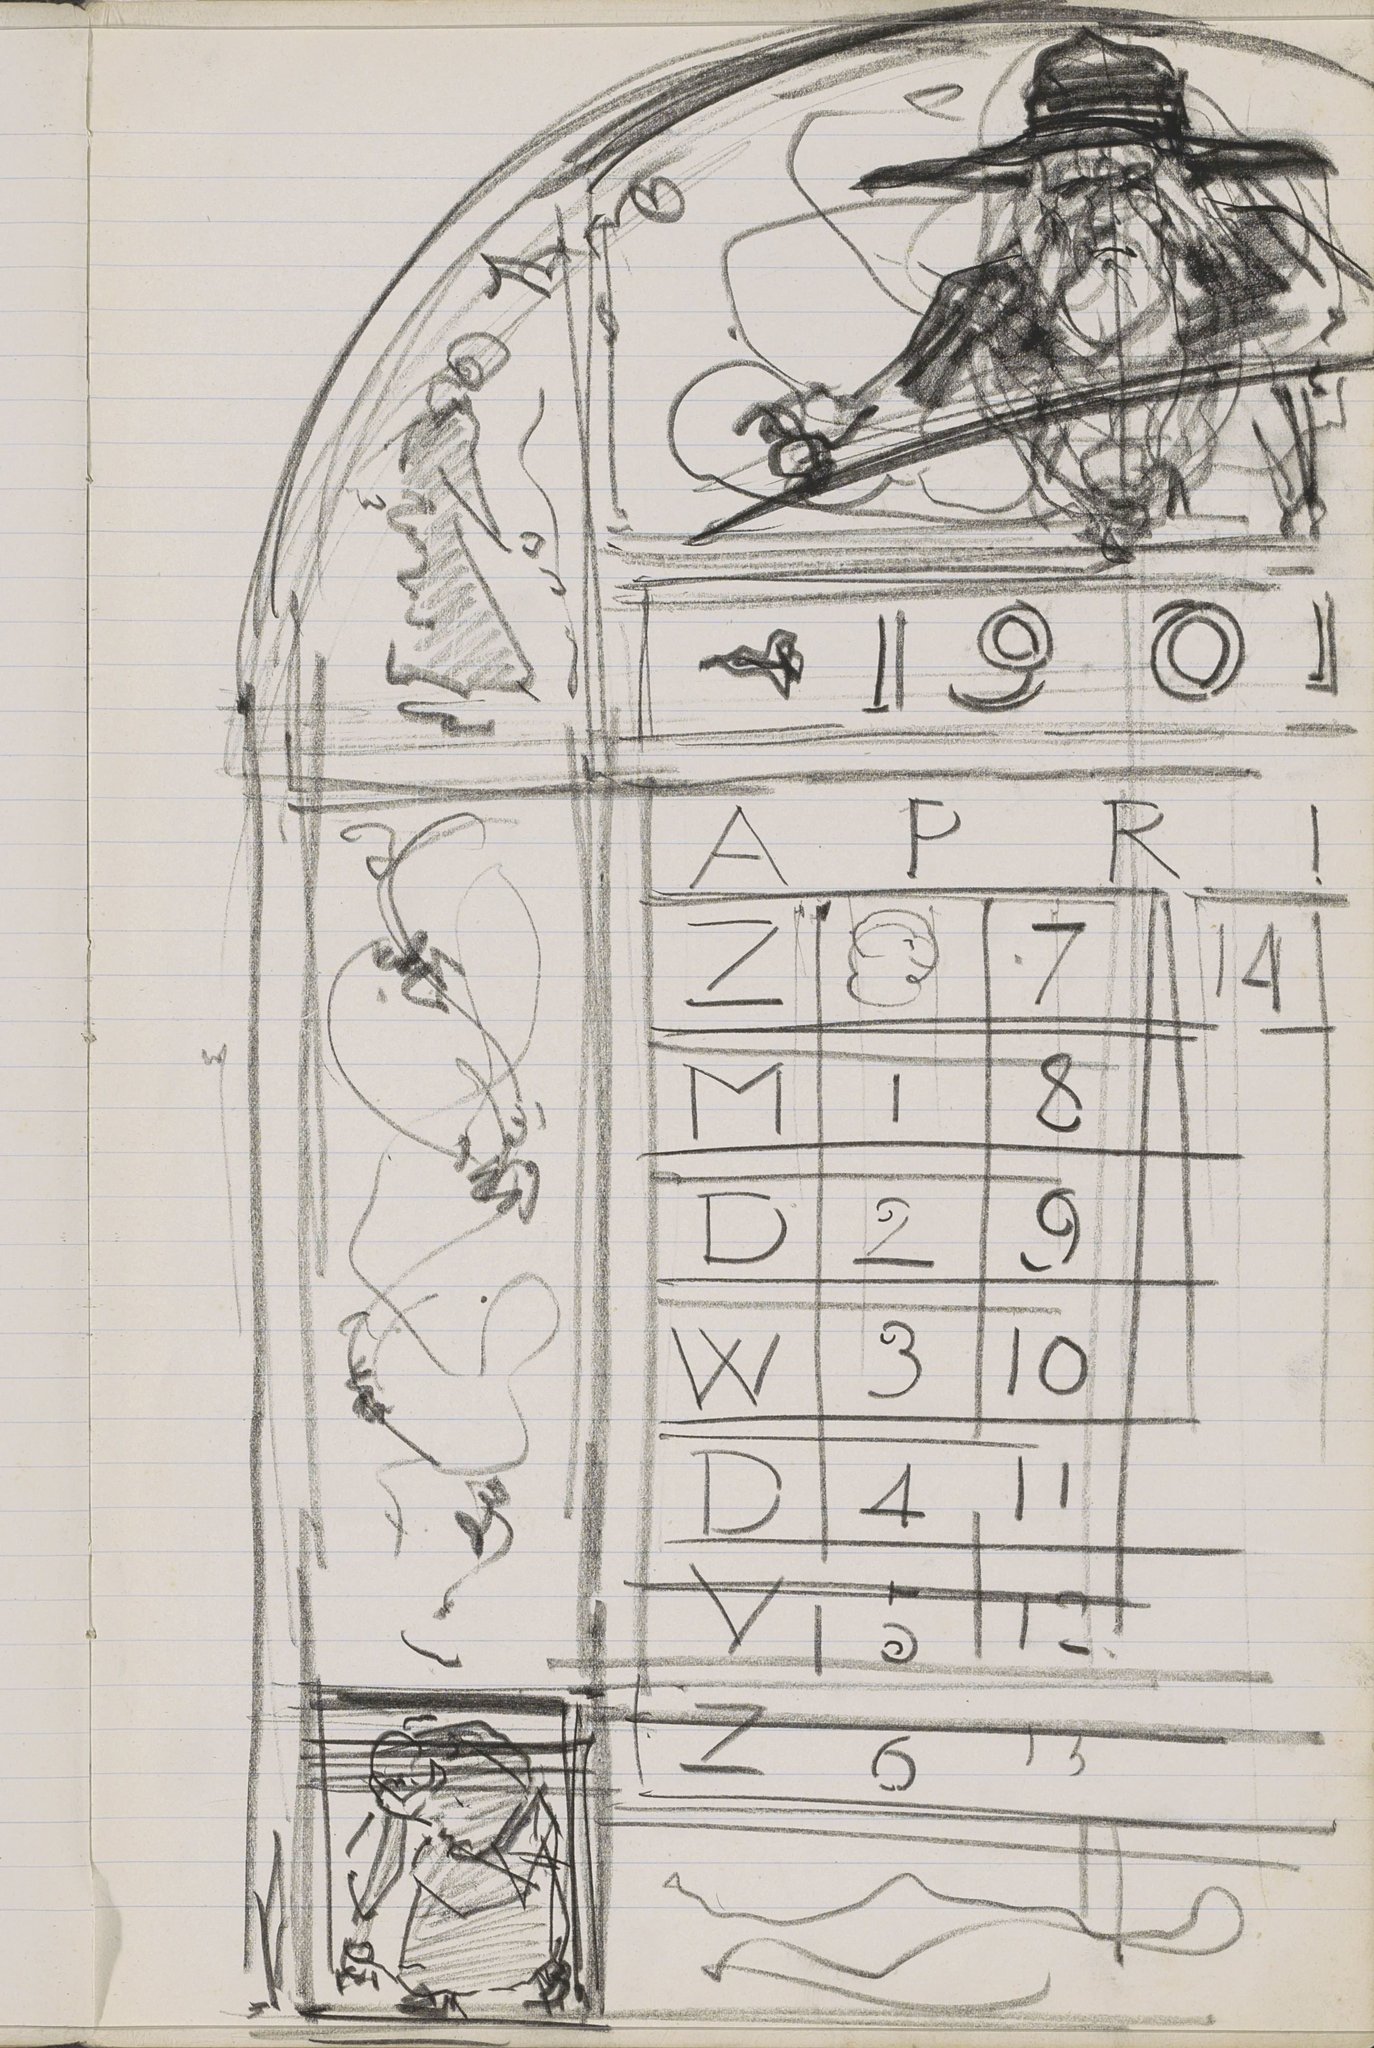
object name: sketchbook leaf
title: Ontwerp voor een kalender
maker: gerrit willem dijsselhof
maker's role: designer, draughtsman, print maker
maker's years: 1866-1924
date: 1901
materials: chalk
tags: calendar, almanac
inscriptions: annotation: ‘1901/ APRIL/ [...]’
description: Blad 4 recto uit een schetsboek met 79 bladen.